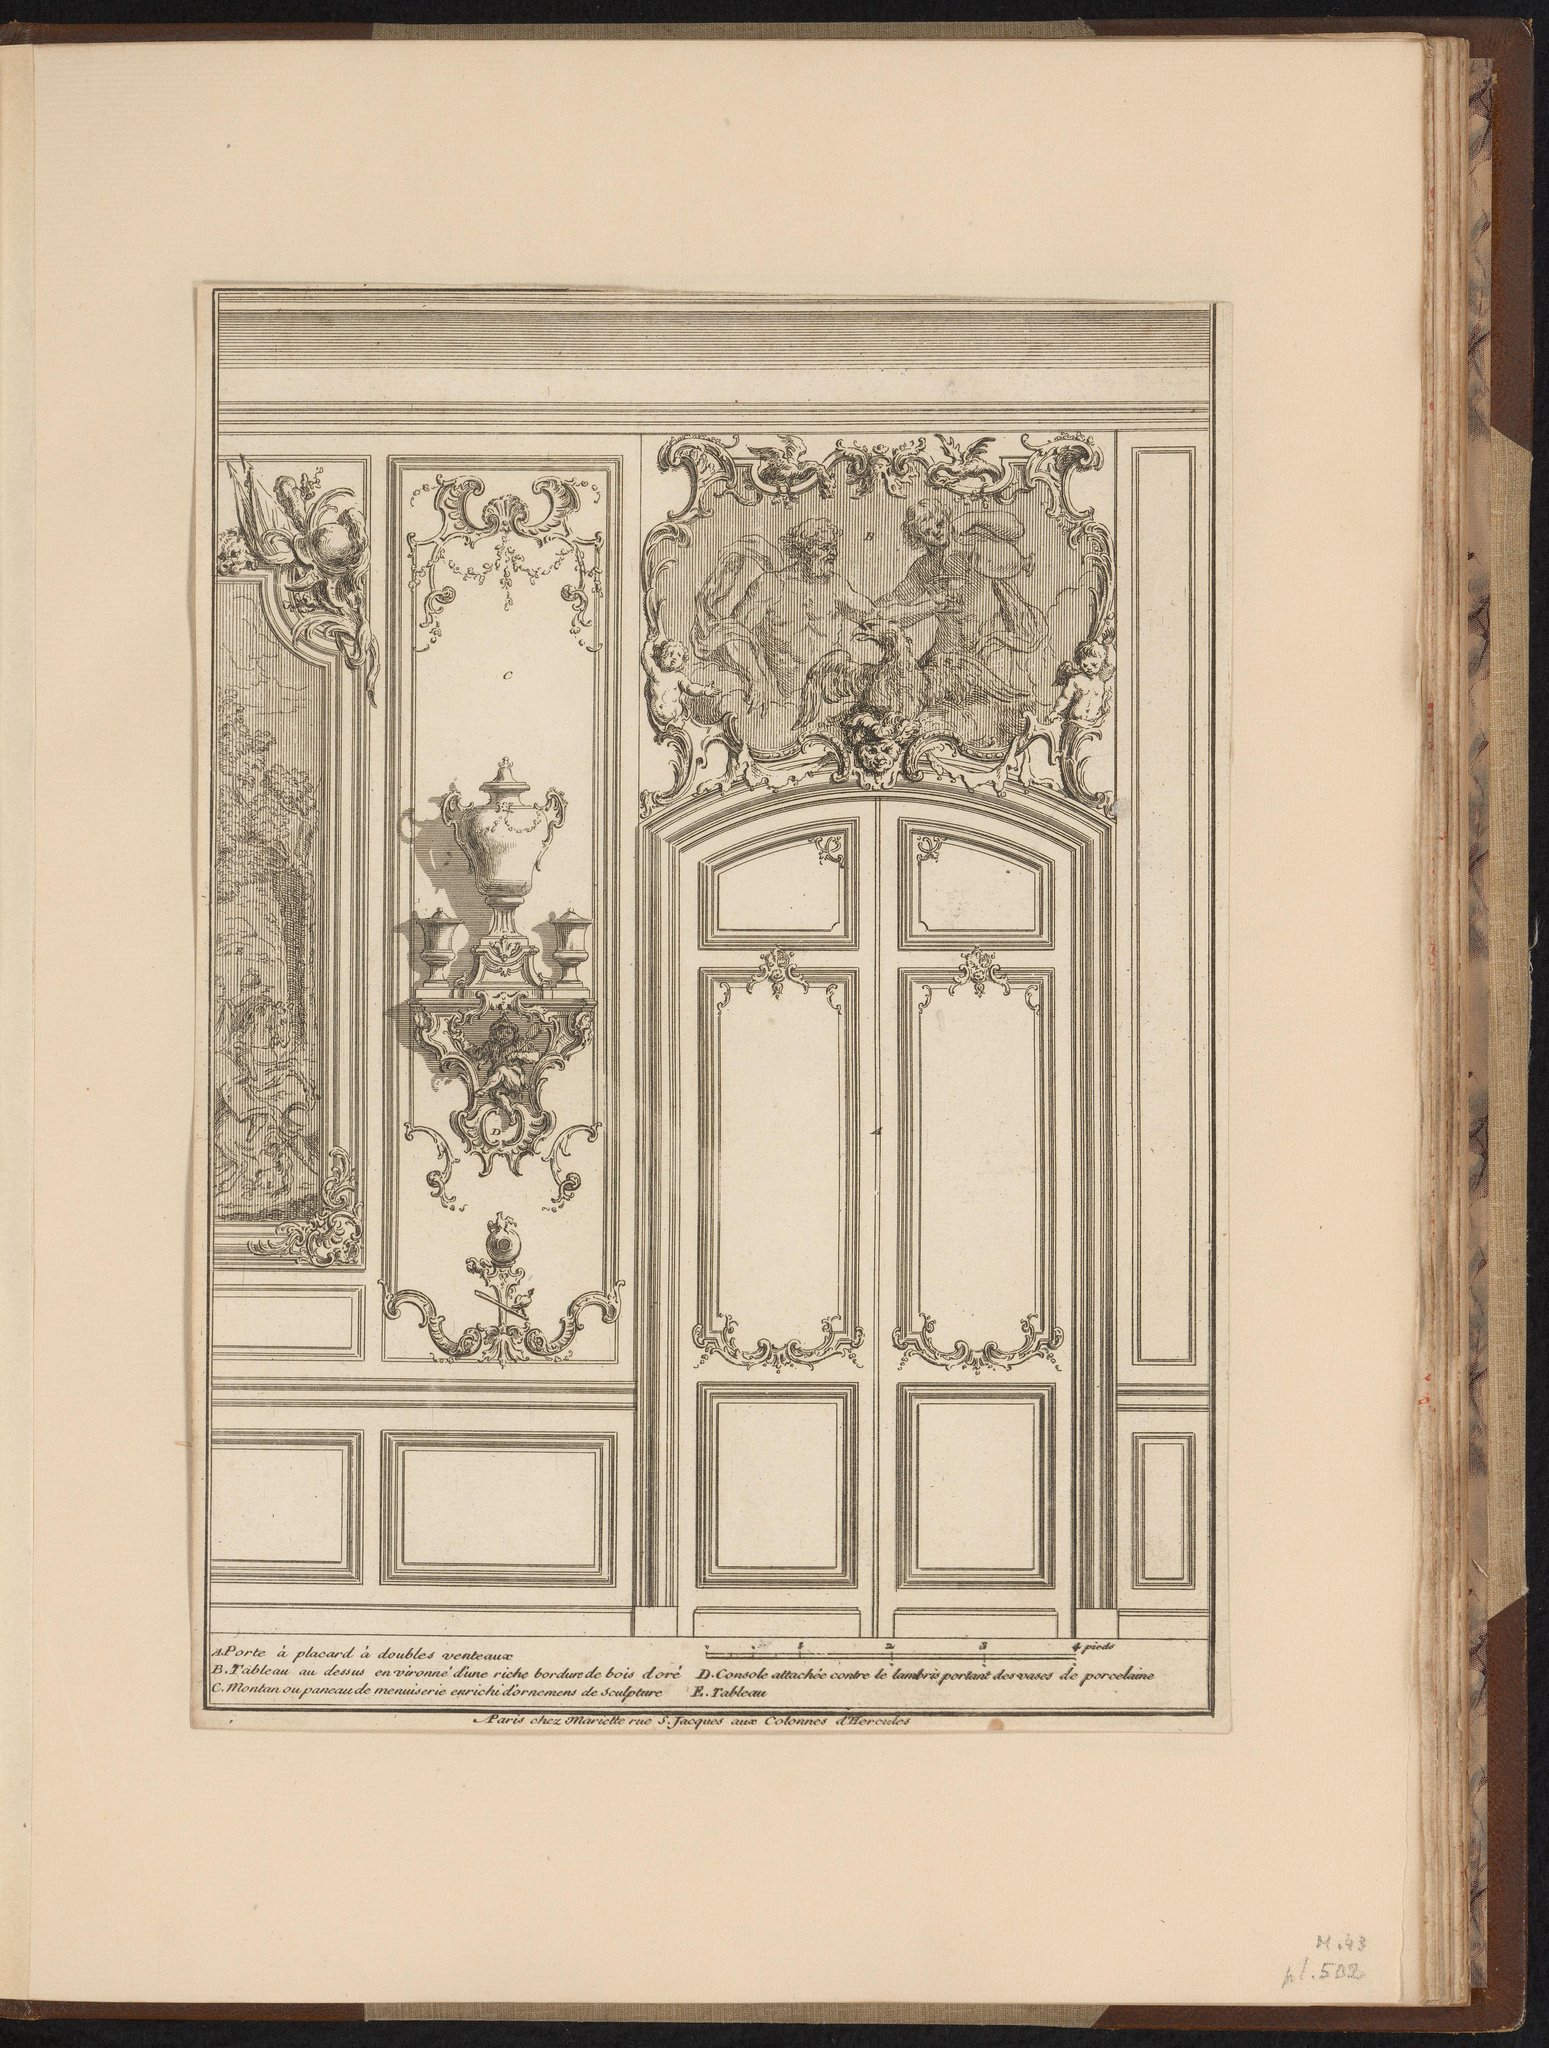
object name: album leaf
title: Ontwerp voor een interieur met vaas op console en dubbele deur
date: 1725-1750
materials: paper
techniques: etching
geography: paris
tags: ornaments ~ art, vase ~ ornament, door, interior of the house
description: Deze prent maakt deel uit van een album.